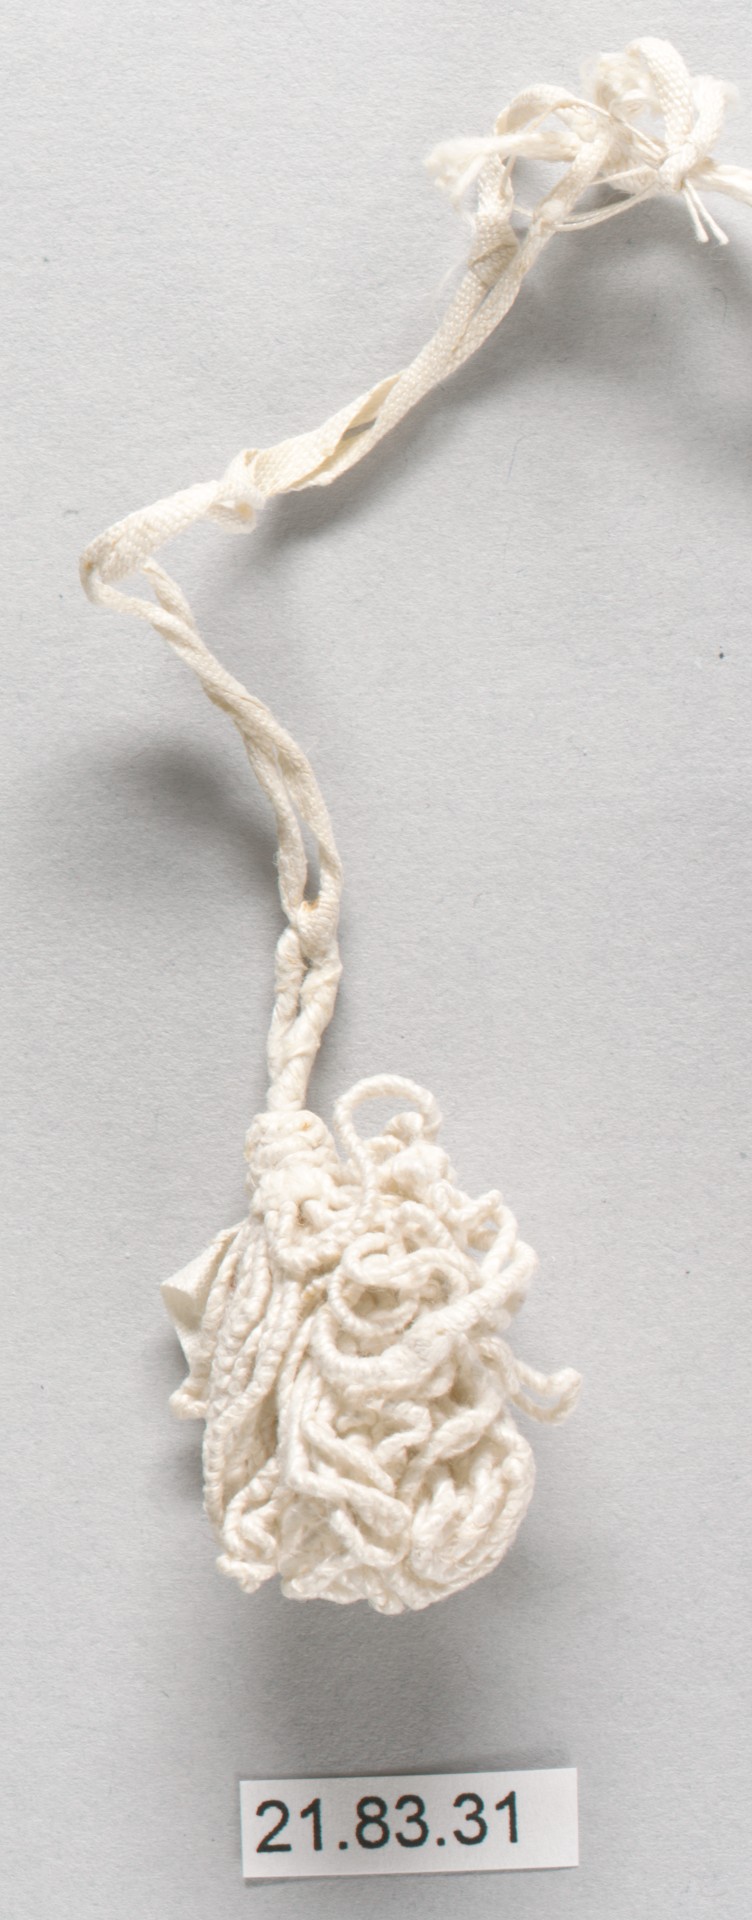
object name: tassel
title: Pair of tassels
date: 1601-1700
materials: linen